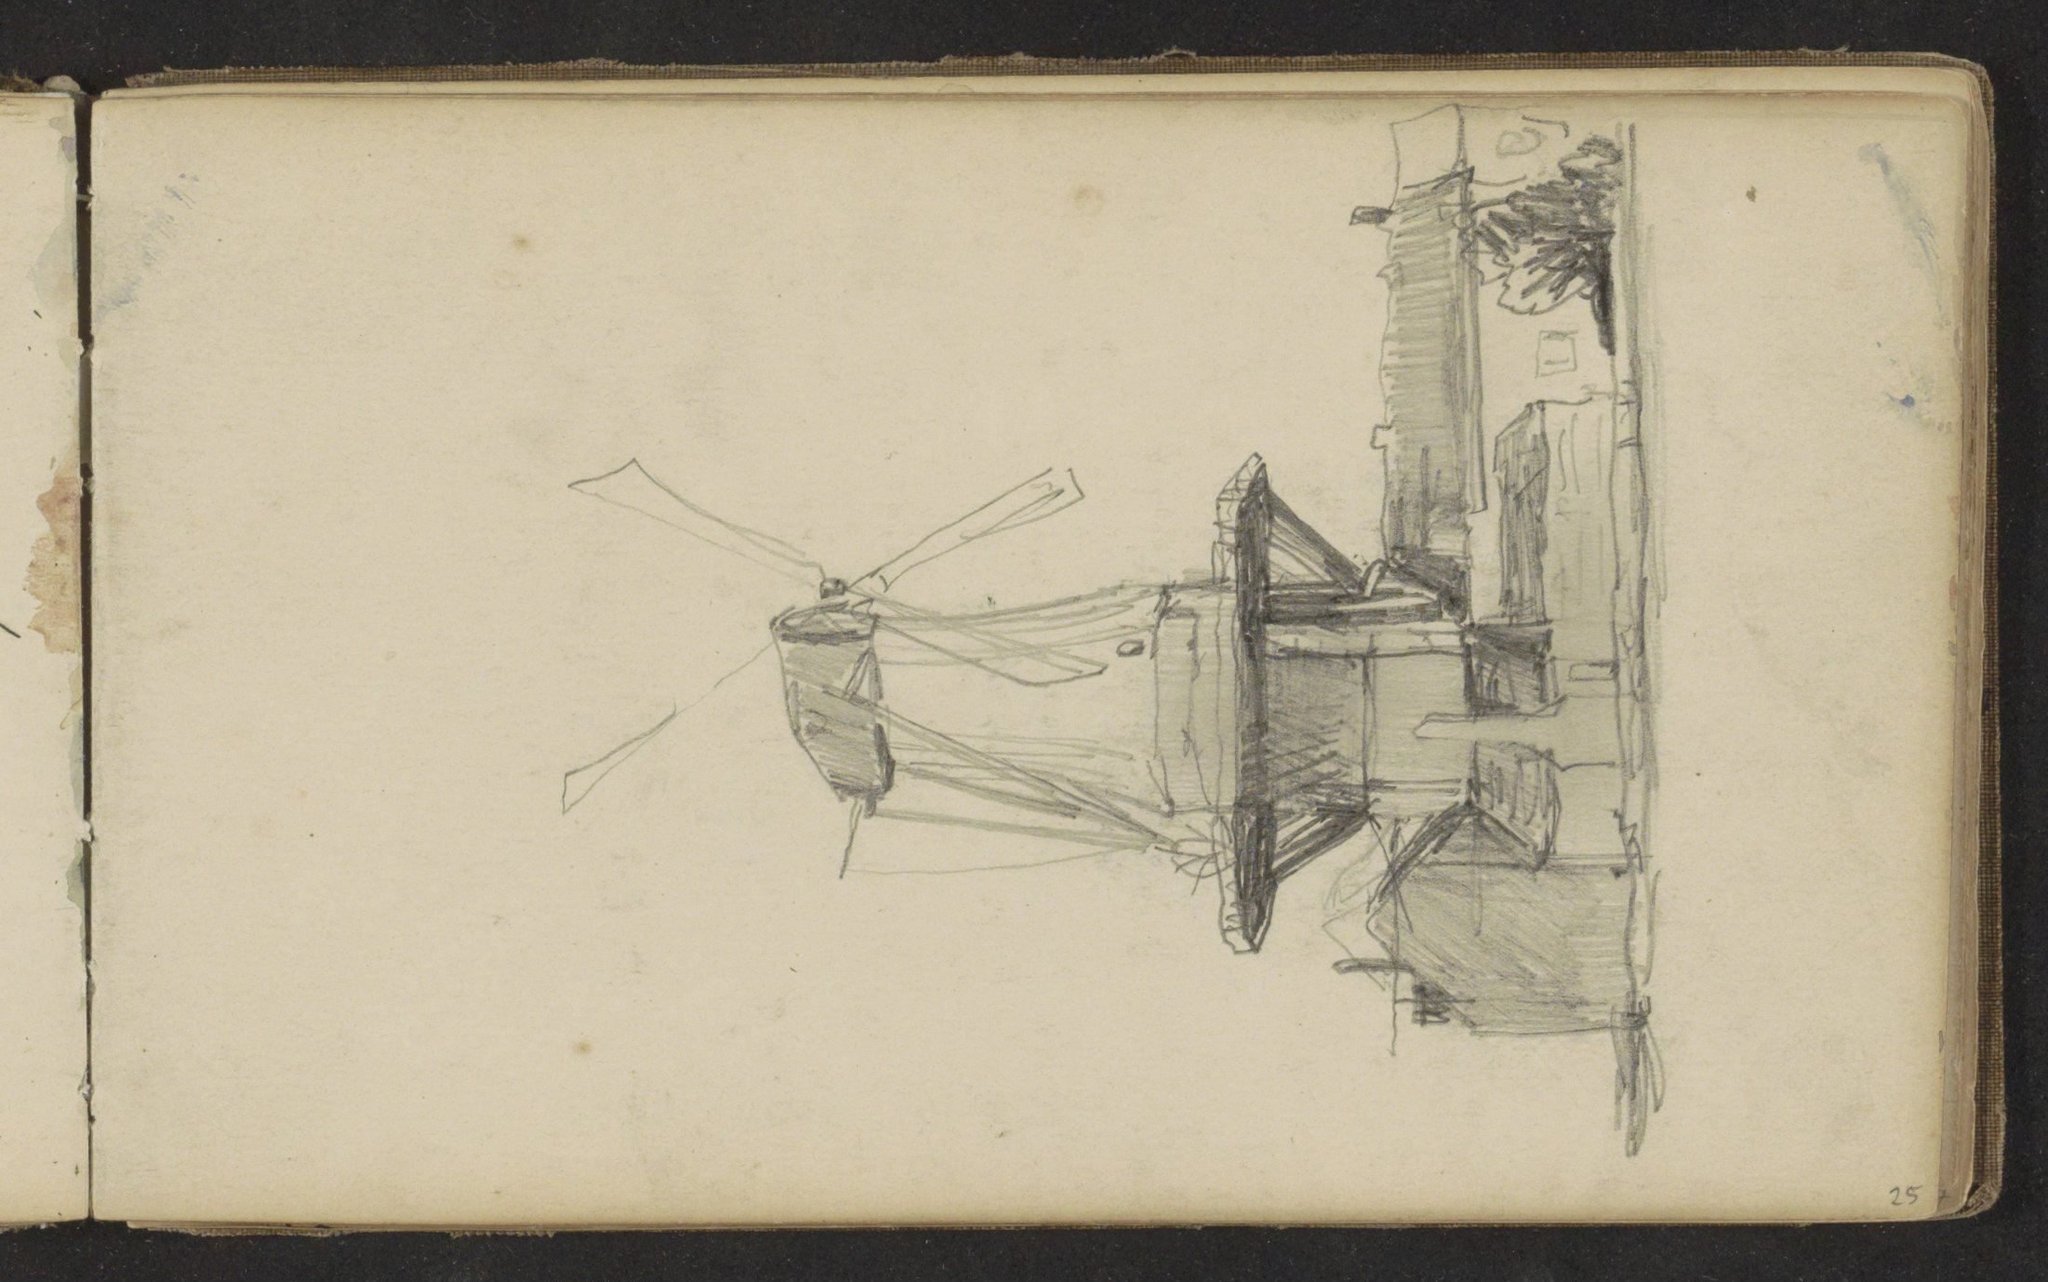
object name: sketchbook leaf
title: Korenmolen De Haas in Den Haag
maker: johan hendrik weissenbruch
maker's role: draughtsman, painter, print maker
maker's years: 1824-1903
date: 1834-1903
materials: paper, pencil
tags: windmill, the hague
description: Blad 25 recto uit een schetsboek met 43 bladen.